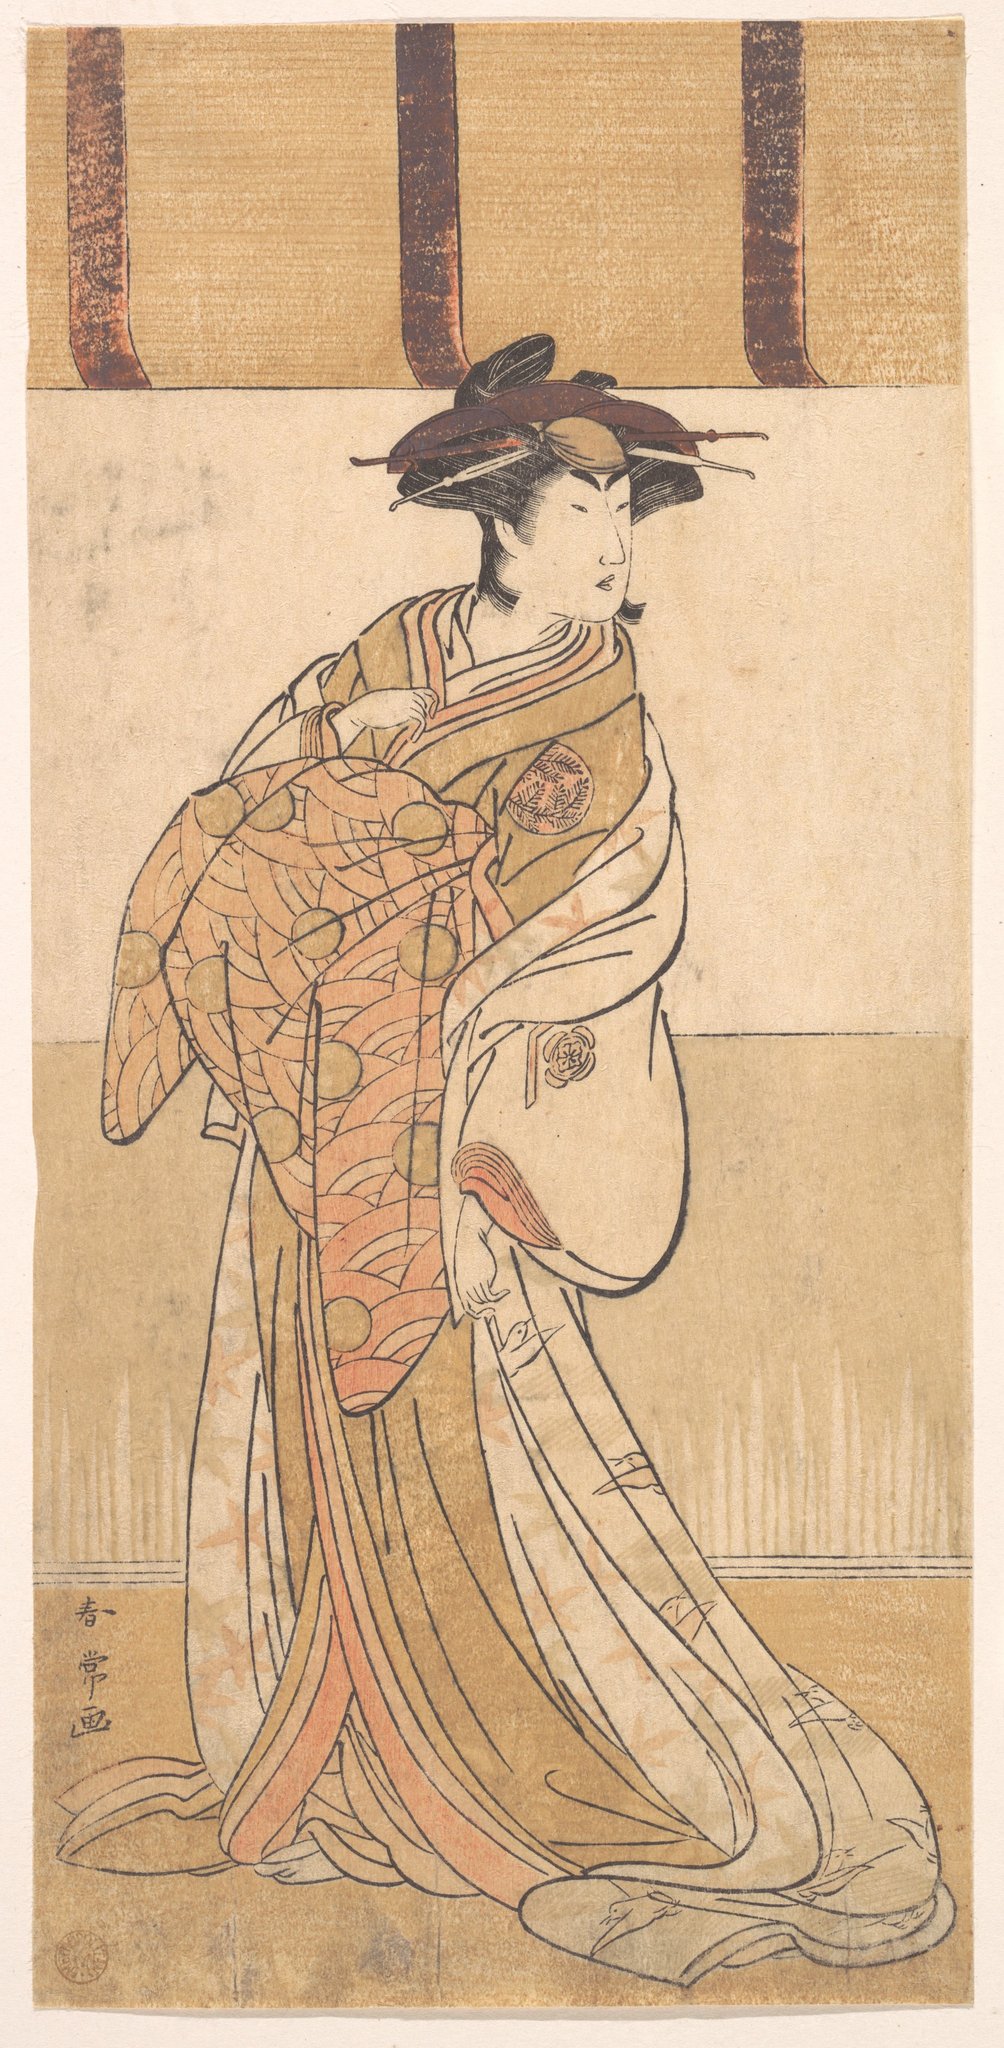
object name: print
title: Nakamura Riko in the Role of Oiso no Tora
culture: japanese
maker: katsukawa shunjō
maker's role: artist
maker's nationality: japanese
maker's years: 1700-1787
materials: ink, paper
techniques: woodblock print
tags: women,actors